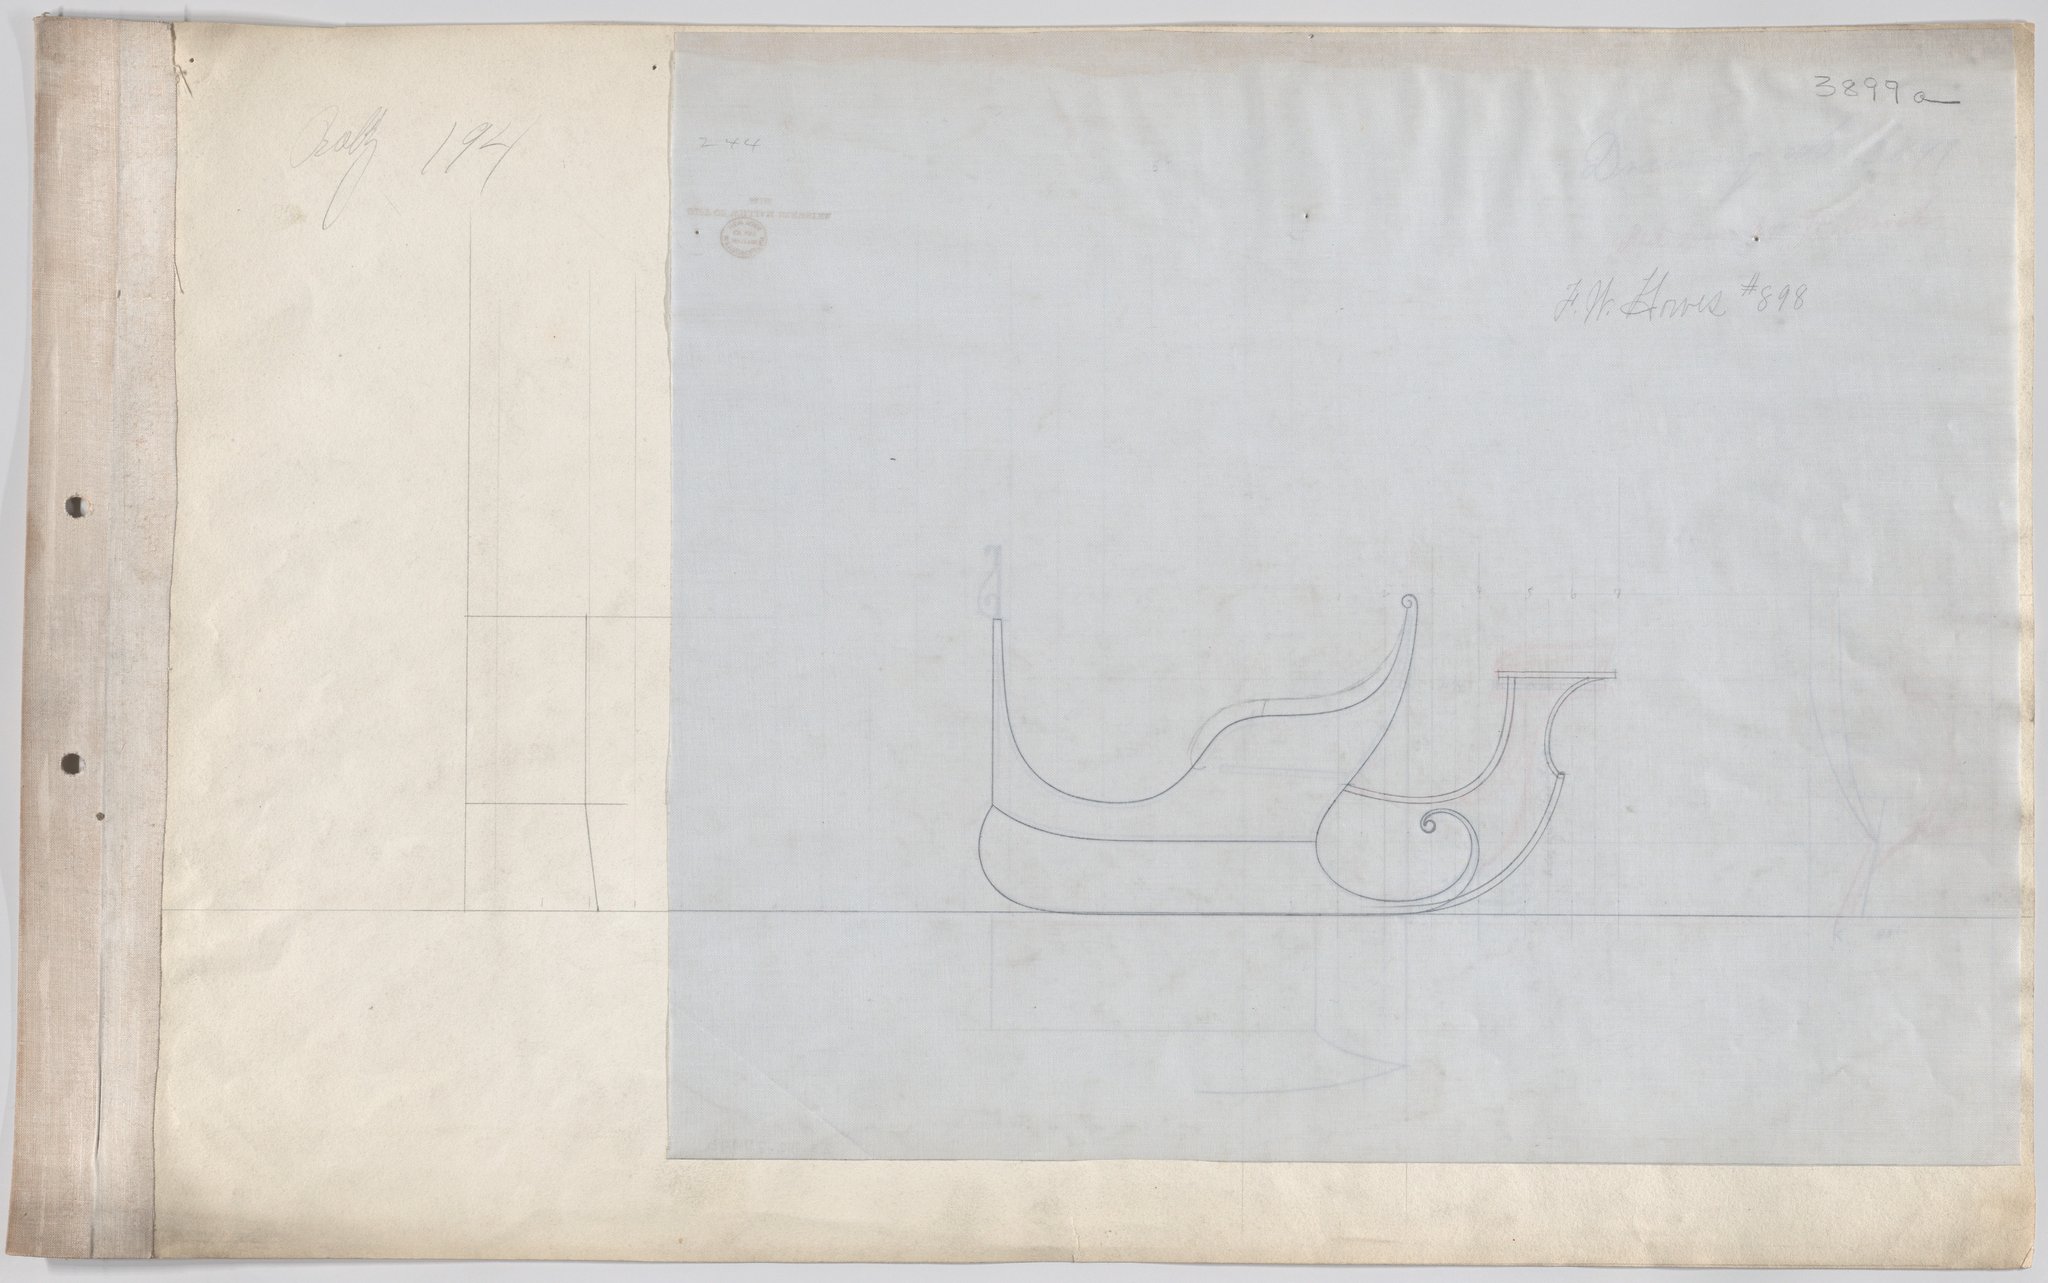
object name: drawing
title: Tub/Carriole Sleigh #3899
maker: brewster & co.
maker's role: manufacturer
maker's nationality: american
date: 1884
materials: crayon, graphite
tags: sleighs